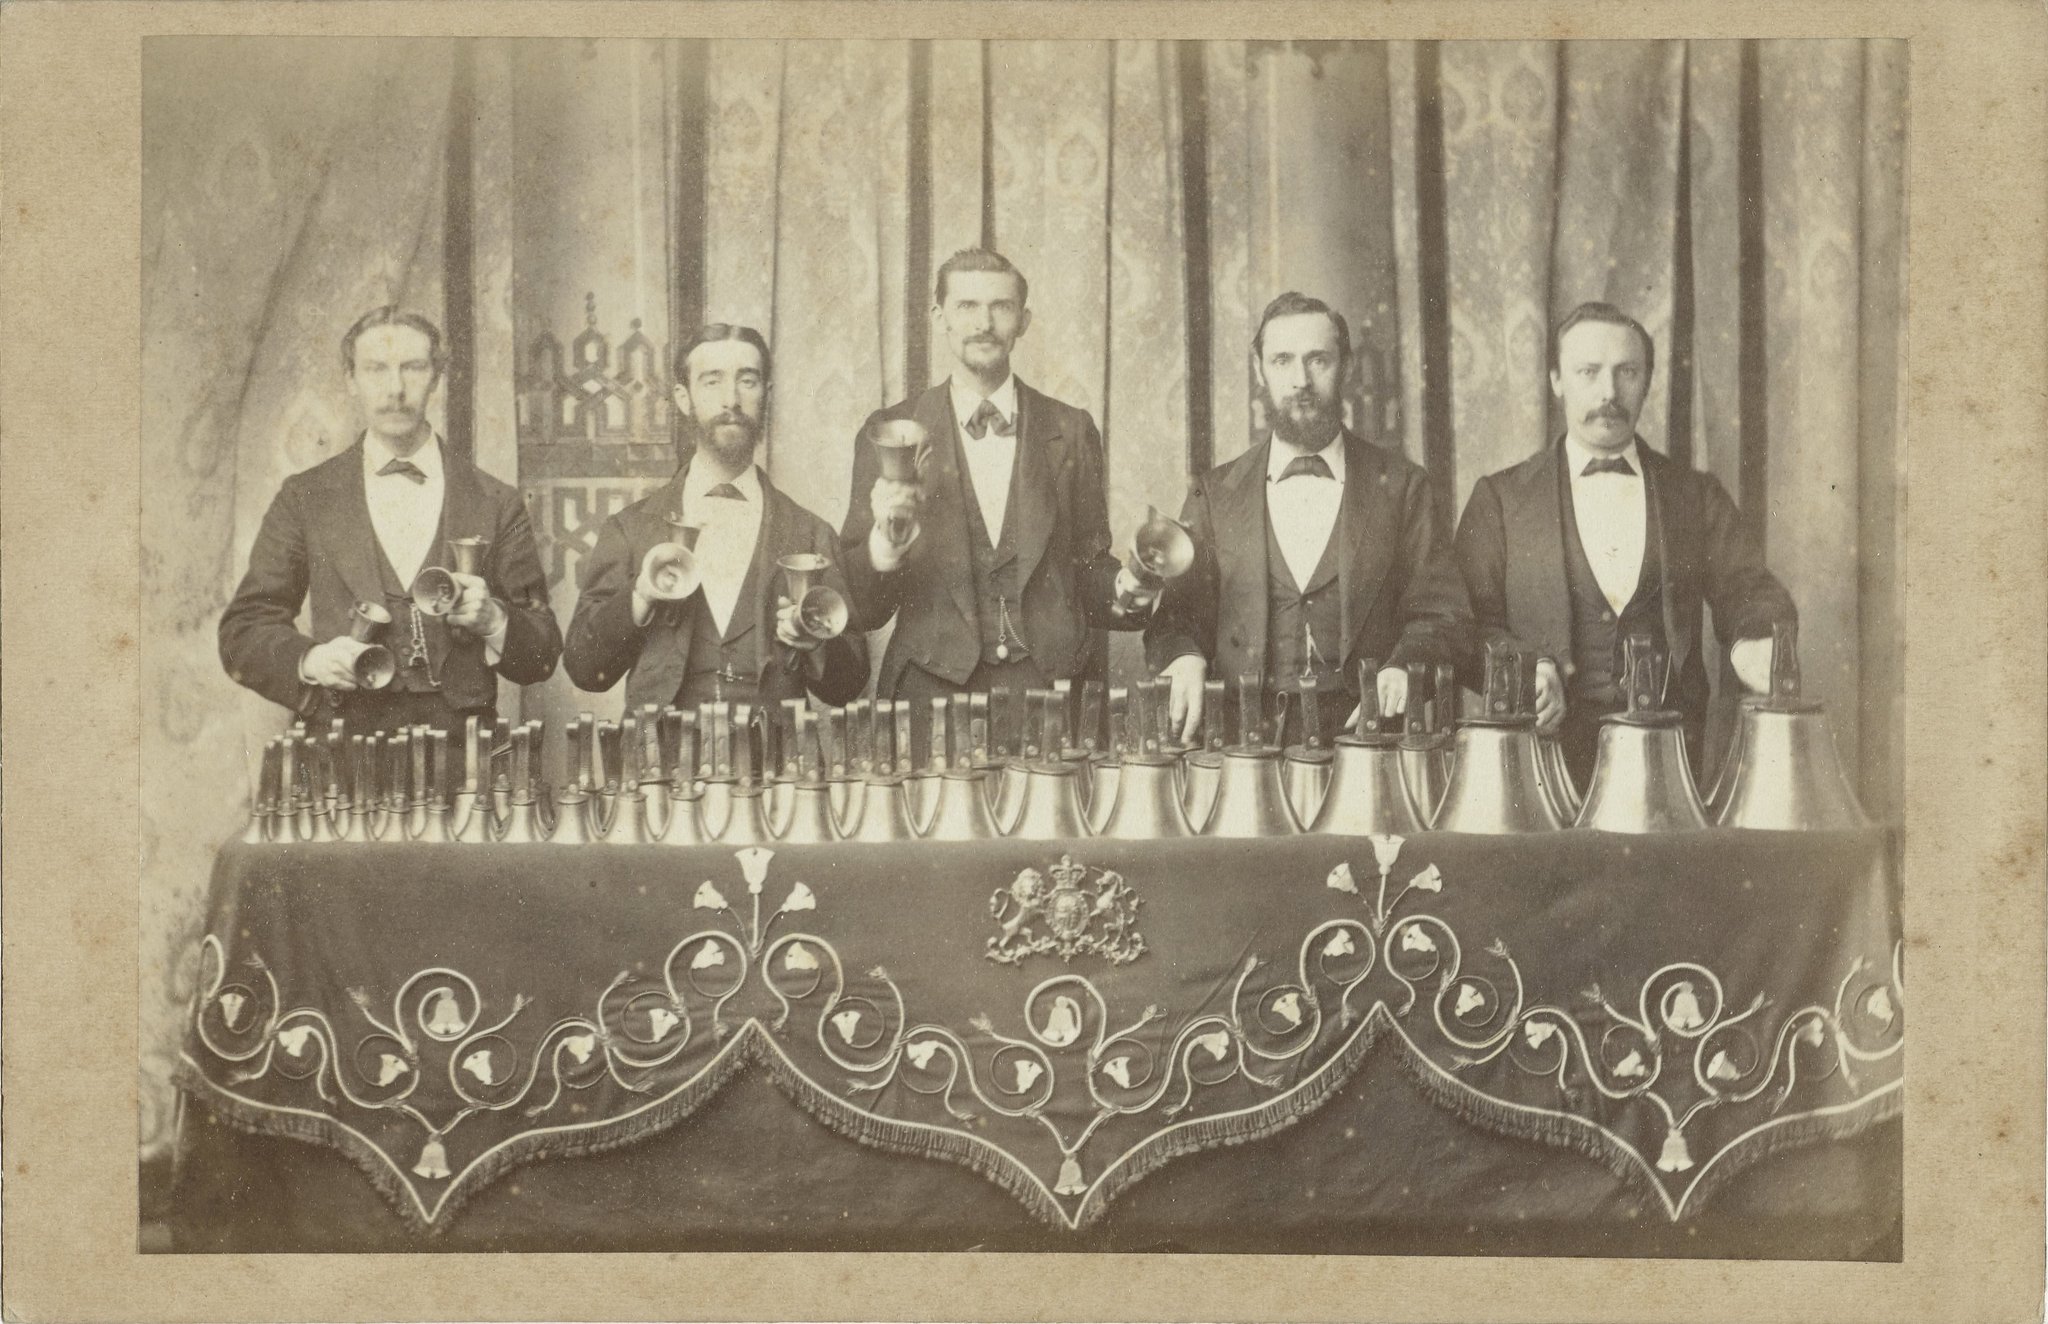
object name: cabinet photograph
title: Groepsportret van de Koninklijke Klokkenspelers uit Londen met hun 131 klokken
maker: Anonymous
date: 1851-1900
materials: cardboard, paper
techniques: albumen print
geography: london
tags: musician, bell ~ musical instruments, portrait of a musician, london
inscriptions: inscription: ‘De Koninklijke Klokkenspelers,/ (POLAND STREET, LONDON.)/ met hunne collectie van 131 klokken./ Het gezelschap betstaat uit de Heeren/ (1.) A.G. PRITCHARD. (2.) J.H. WILLIAMS (3.) DUNCAN S. MiILLER, DIRECTEUR./ (4.) H. HAVART. (5.) W.J. HAVART./ En had de eer tweemalen optetreden voor/ Hare Majesteit koningin Victoria en de koninklijke familie,/ te "Osborne" en te "Windsor Castle;" alsook nog voor Z.M./ den Koning van Belgie; H.M. den Koning en de Koningin/ van Griekenland, enz. enz.’